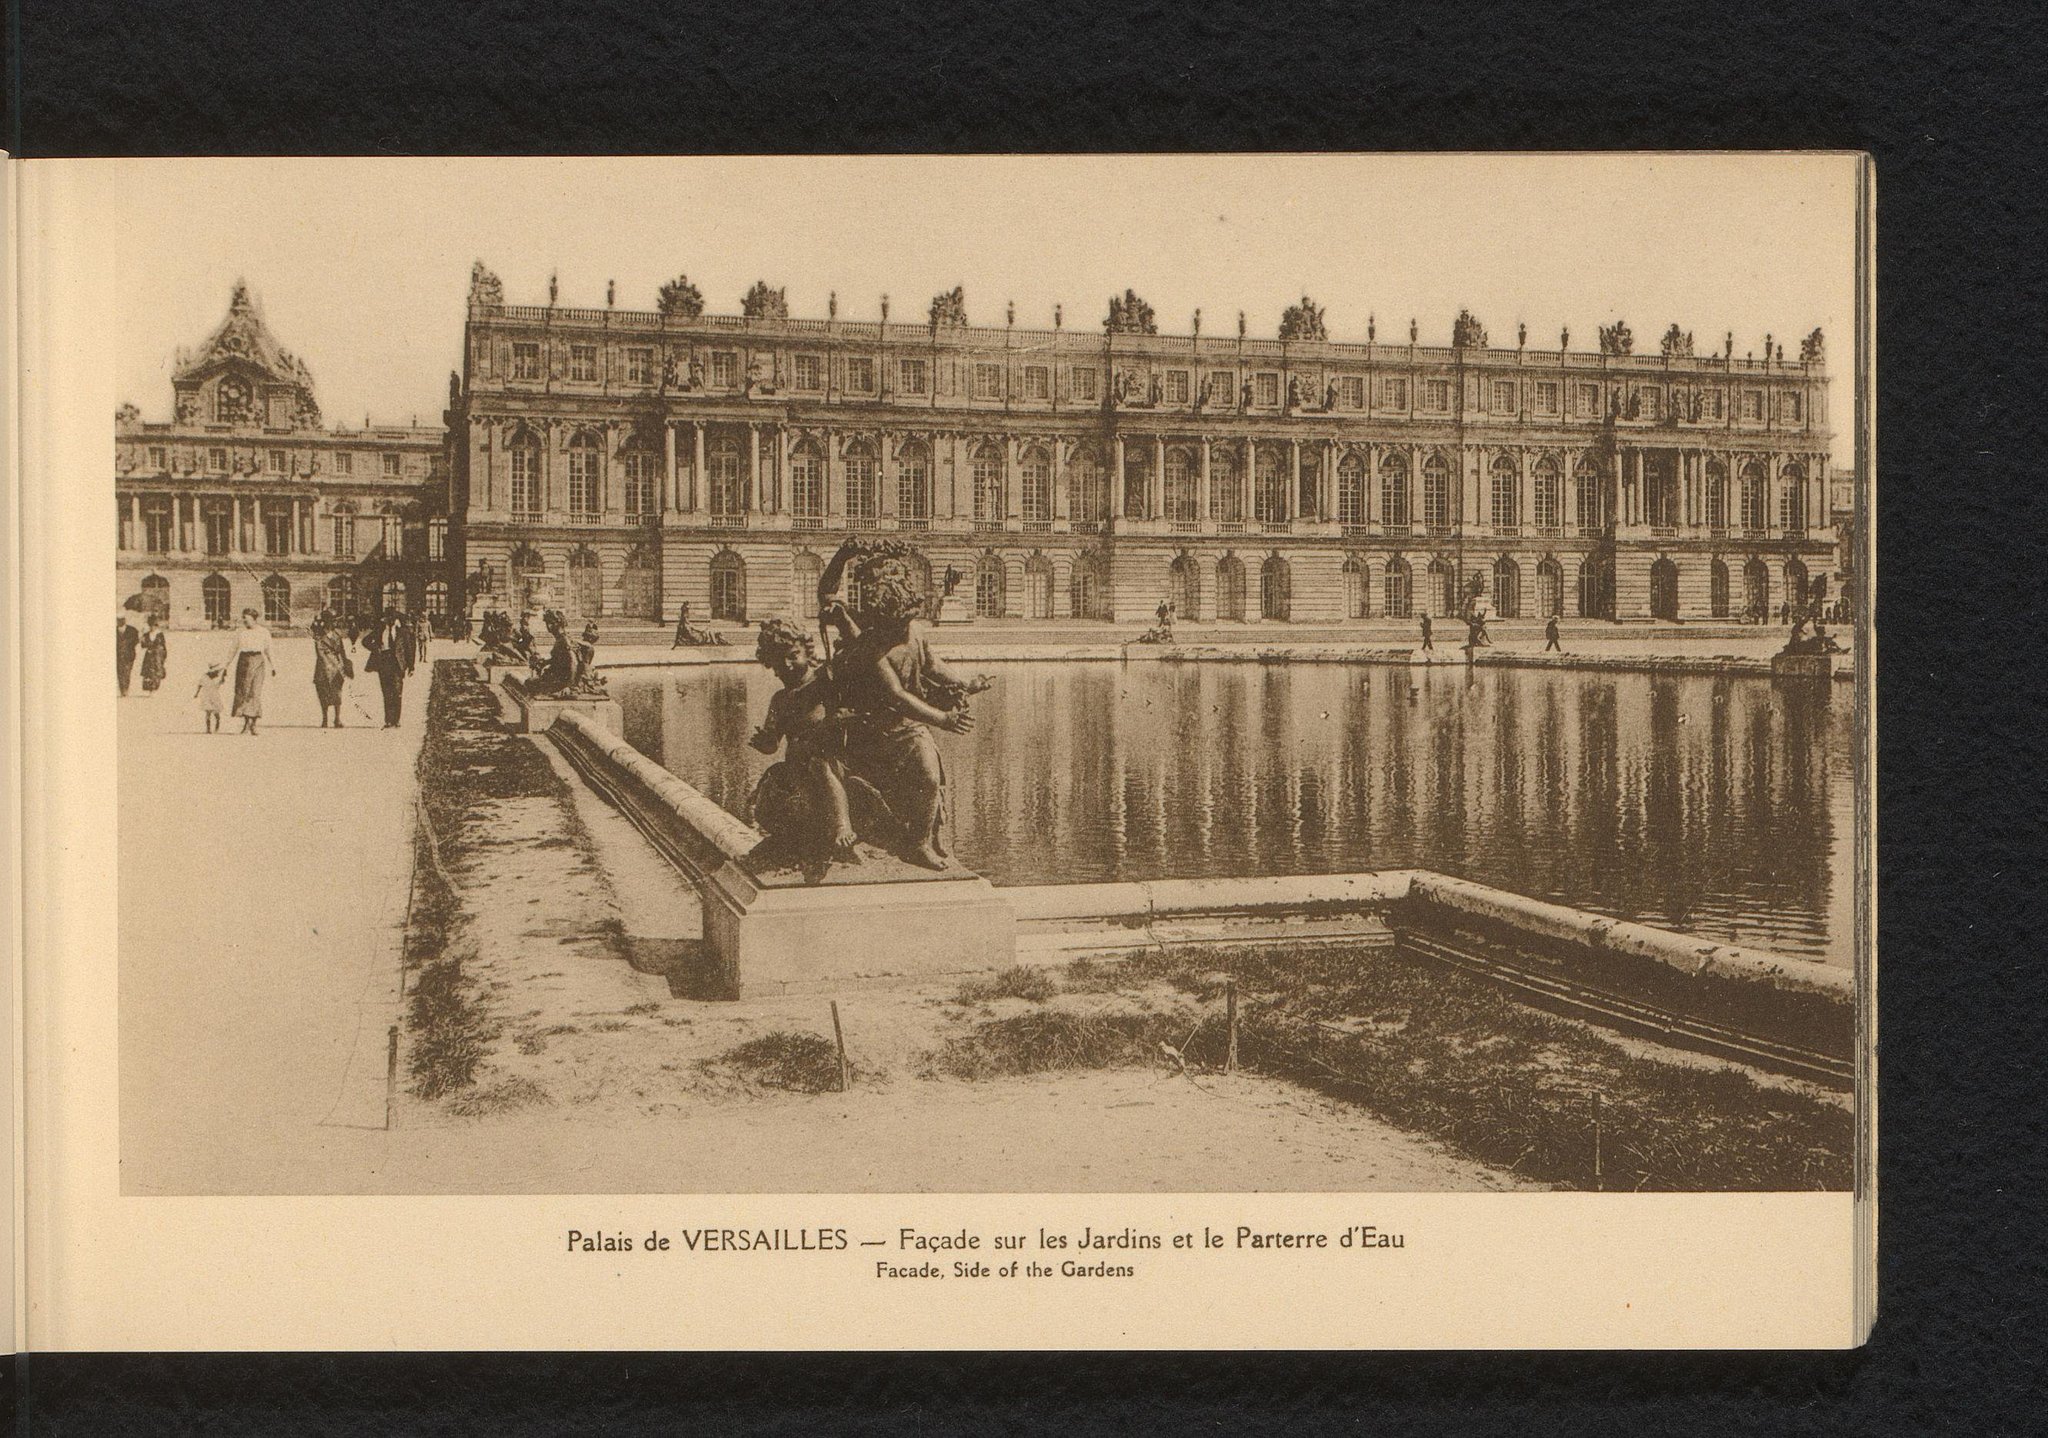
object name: photomechanical print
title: Palais de Versailles. Façade sur les Jardins et le Parterre d'Eau / Facade, Side of the Gardens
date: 1919-1930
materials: cardboard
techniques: photograph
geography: paris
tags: palace, french or architectonic garden; formal garden